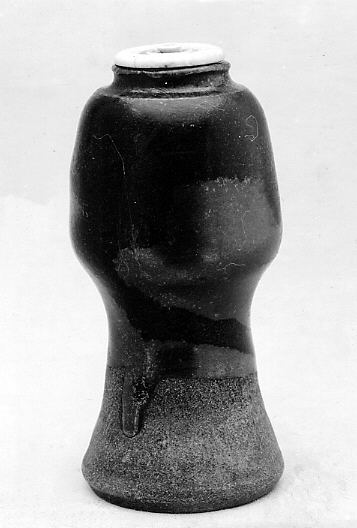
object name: tea jar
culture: japanese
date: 1601-1700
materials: clay, glaze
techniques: overglaze